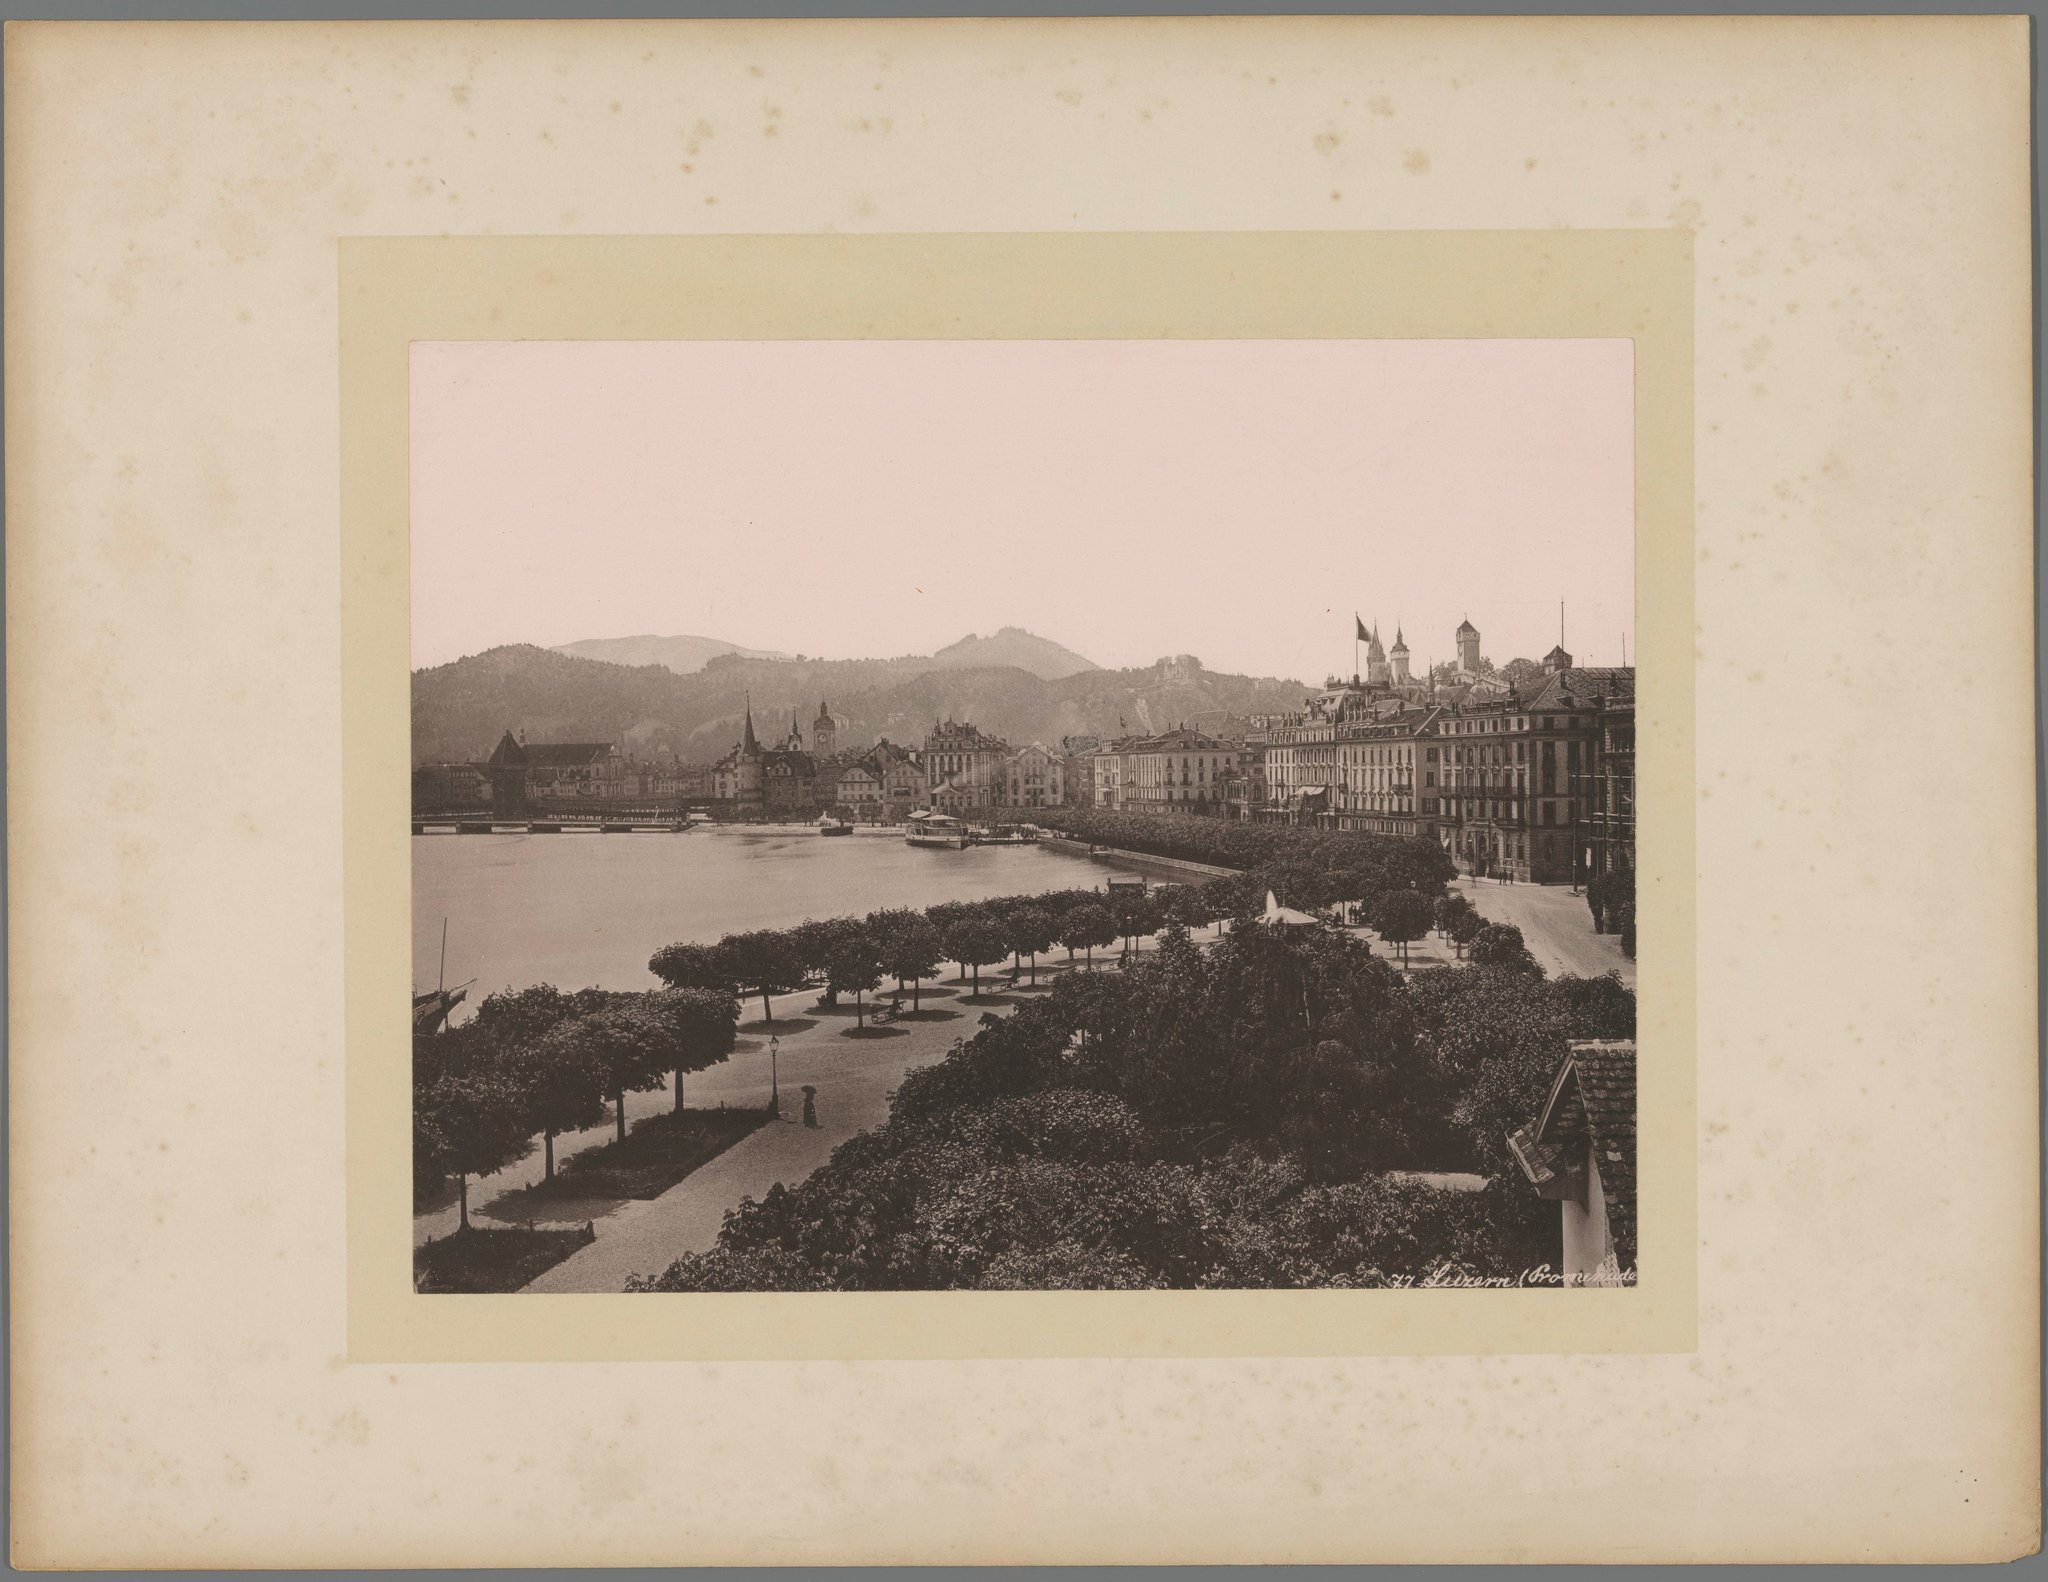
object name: photomechanical print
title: Luzern (Promenade)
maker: Anonymous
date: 1870-1930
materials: cardboard, paper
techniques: photograph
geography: lucerne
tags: city-view in general; 'veduta'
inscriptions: number: ‘77’